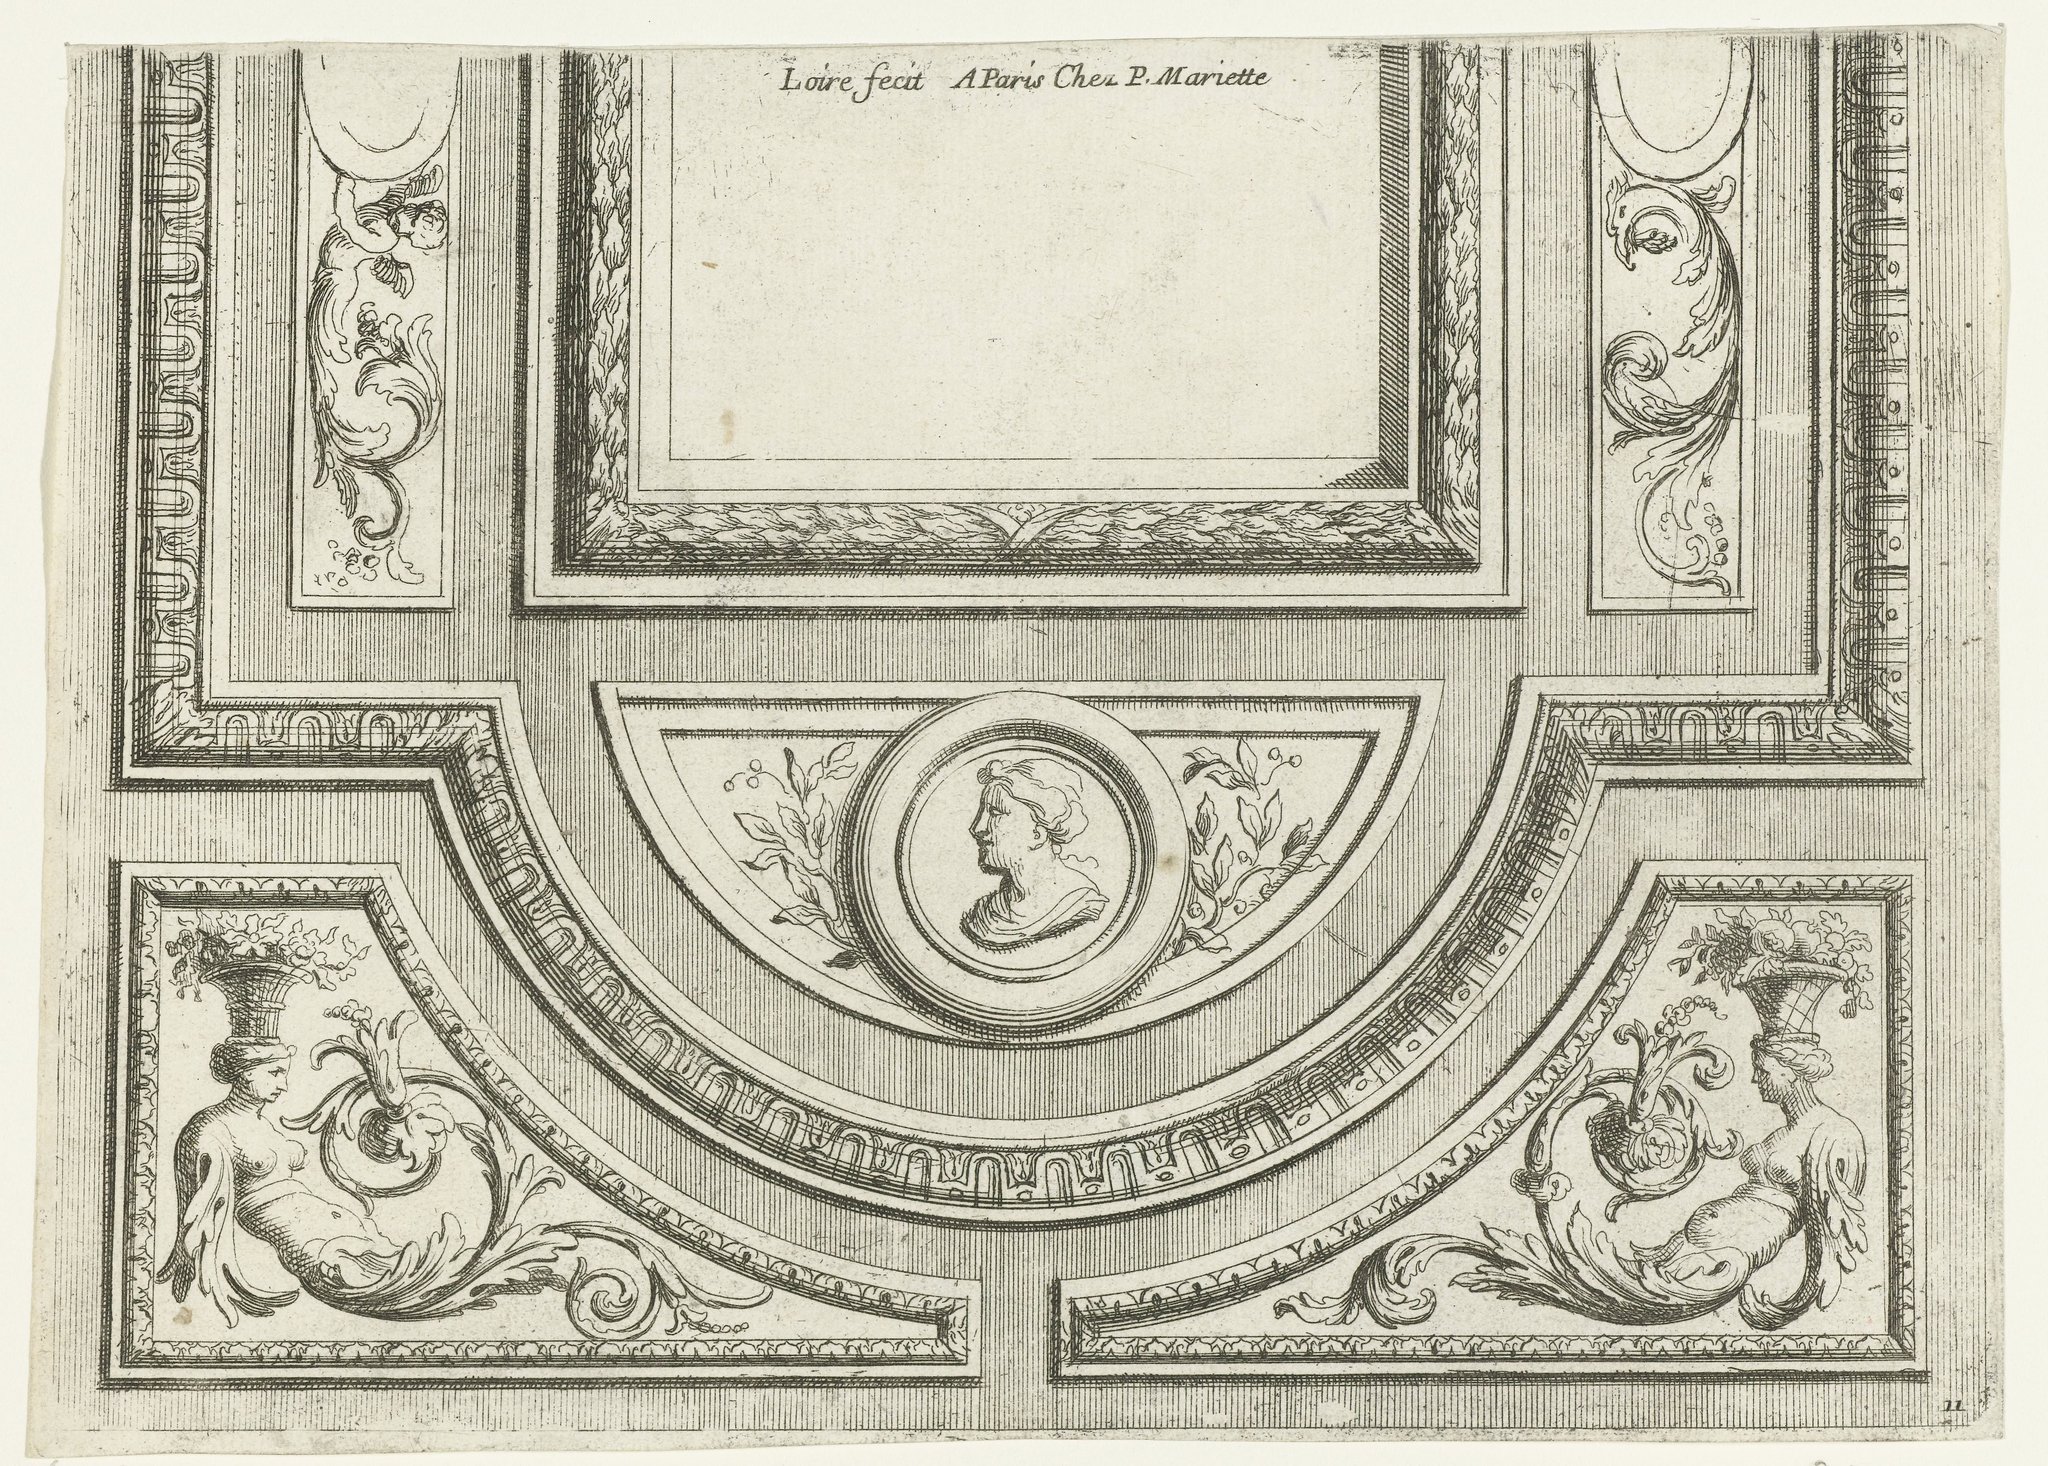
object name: ornament print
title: Half plafond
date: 1634-1716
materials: paper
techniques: etching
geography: france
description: In het midden en leeg vlak, de rand is gescheiden door een geprofileerde lijst. Uit tweede editie.